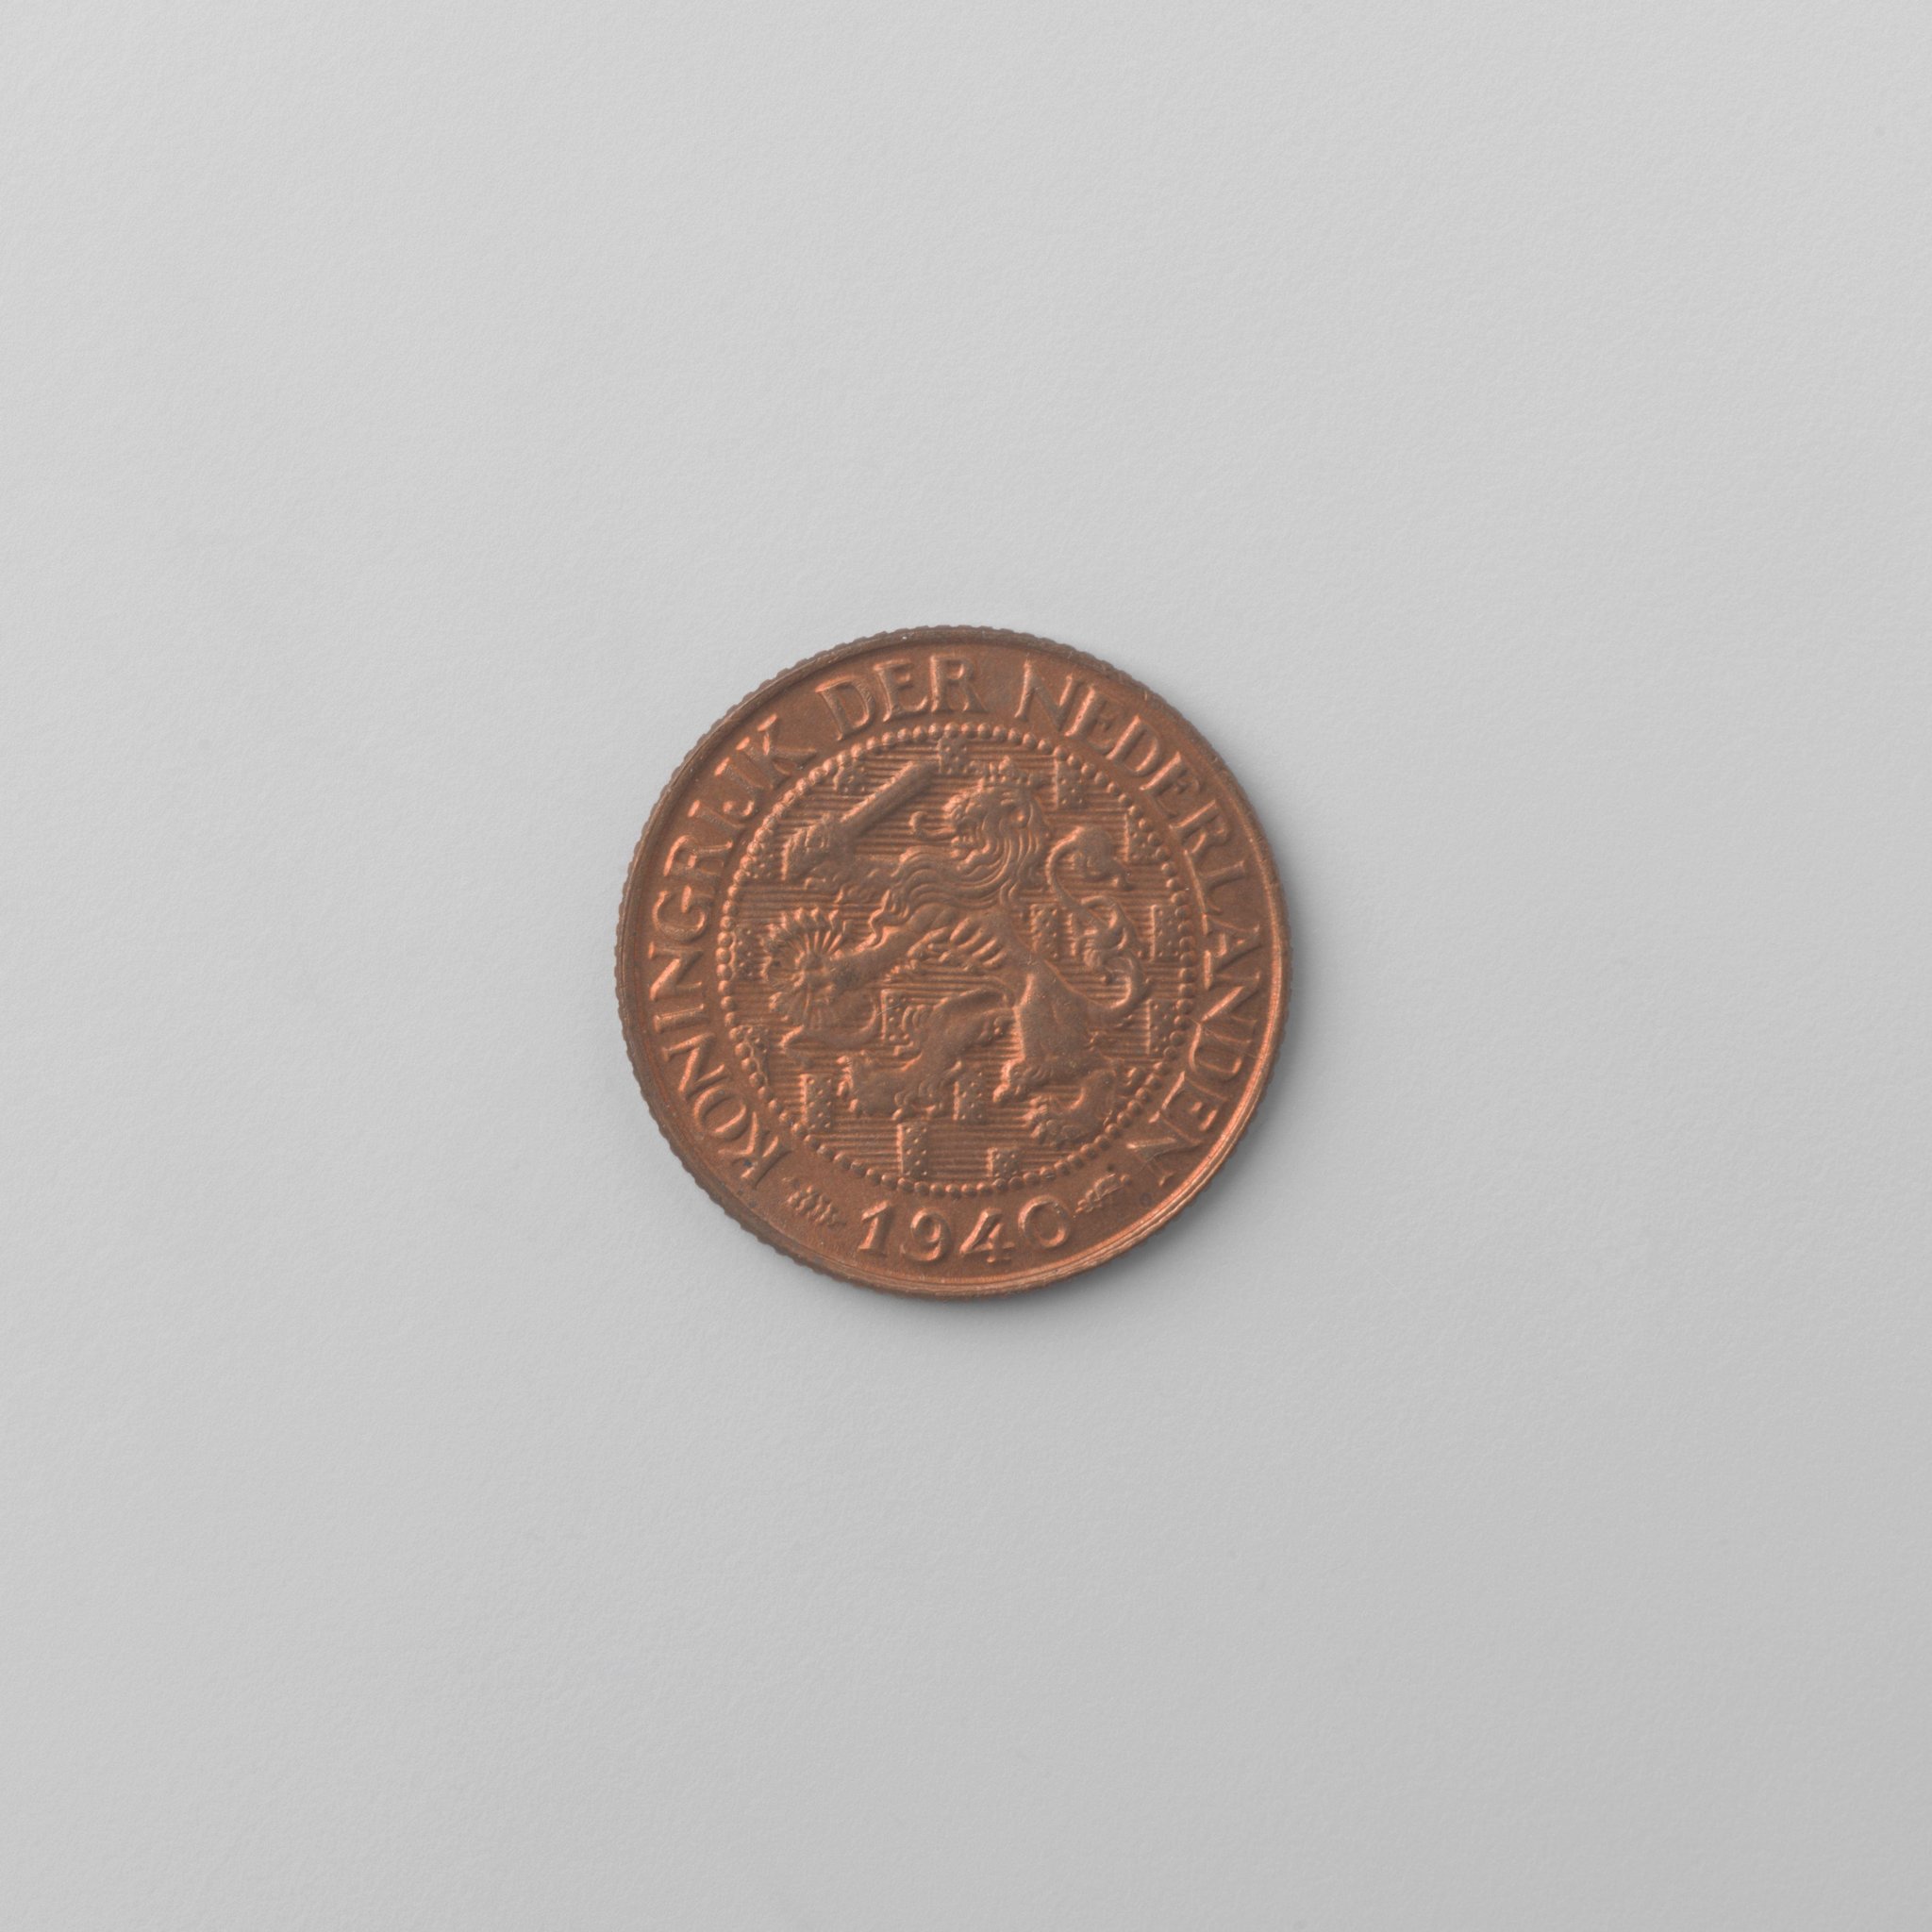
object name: coin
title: Nederlandse cent,1940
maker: wilhelmina of the netherlands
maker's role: print maker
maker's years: 1880-1962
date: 1940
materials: bronze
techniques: striking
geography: utrecht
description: Bronzen munt. Voorzijde: in een veld rijkswapen. Jaartal onderaan in omschrift. Keerzijde: binnen twee samengebonden oranjetakken waarde-aanduiding 1 cent. Kartelrand.